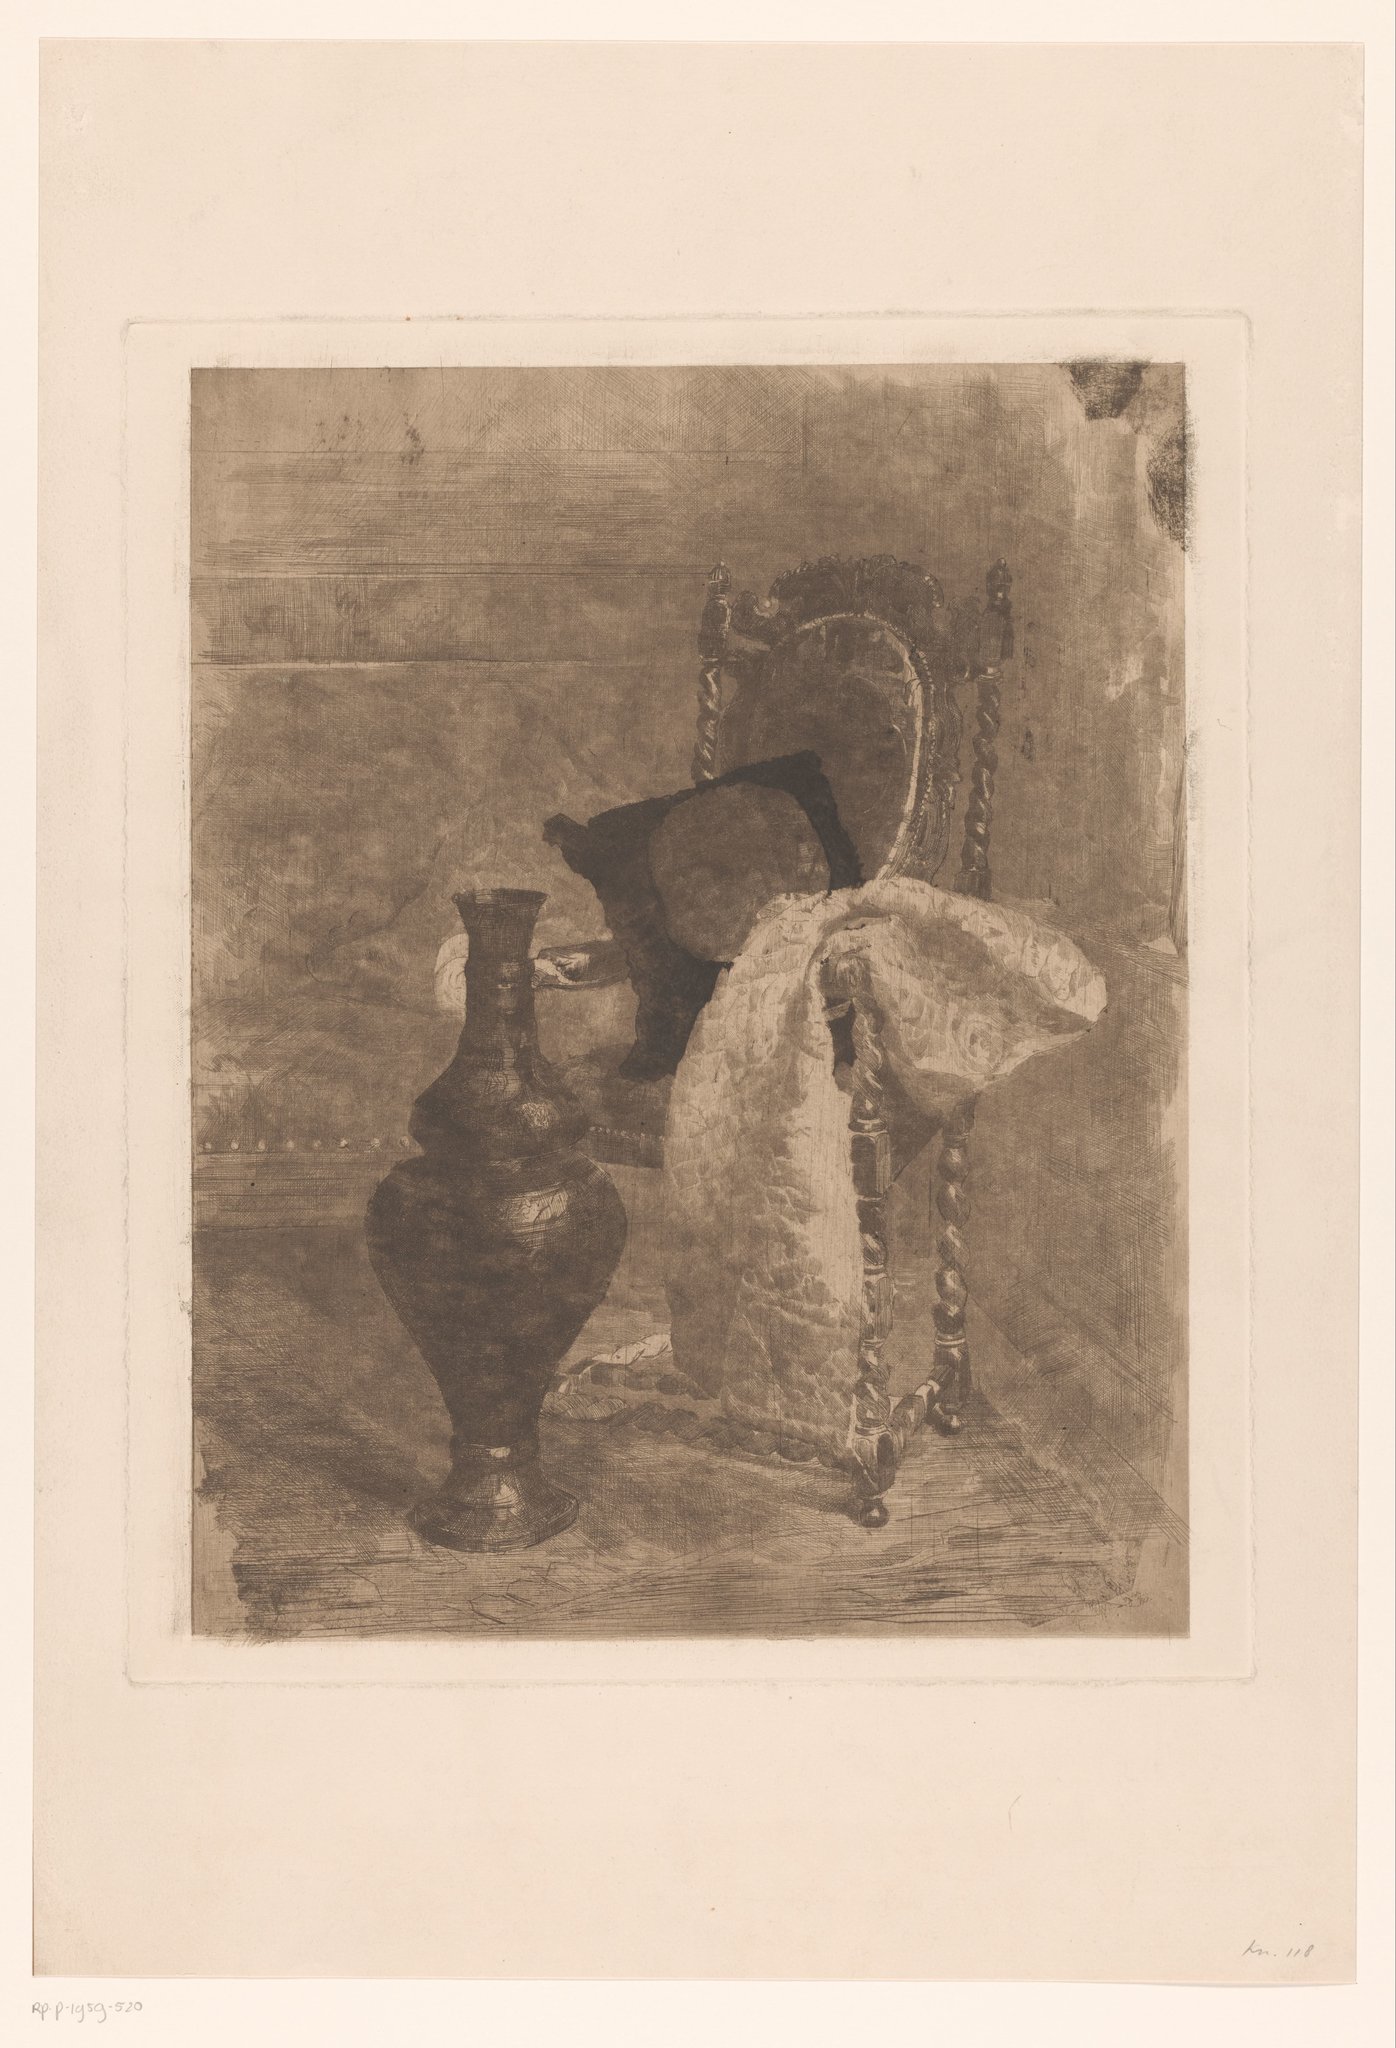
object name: print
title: Stilleven met stoel en vaas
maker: barbara elisabeth van houten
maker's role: draughtsman, print maker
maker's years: 1862-1950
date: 1872-1950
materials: paper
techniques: etching, intaglio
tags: chair, container of metal: bucket, can, canister, drum, tin, still life of miscellaneous objects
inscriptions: collector's mark: Lugt 2228